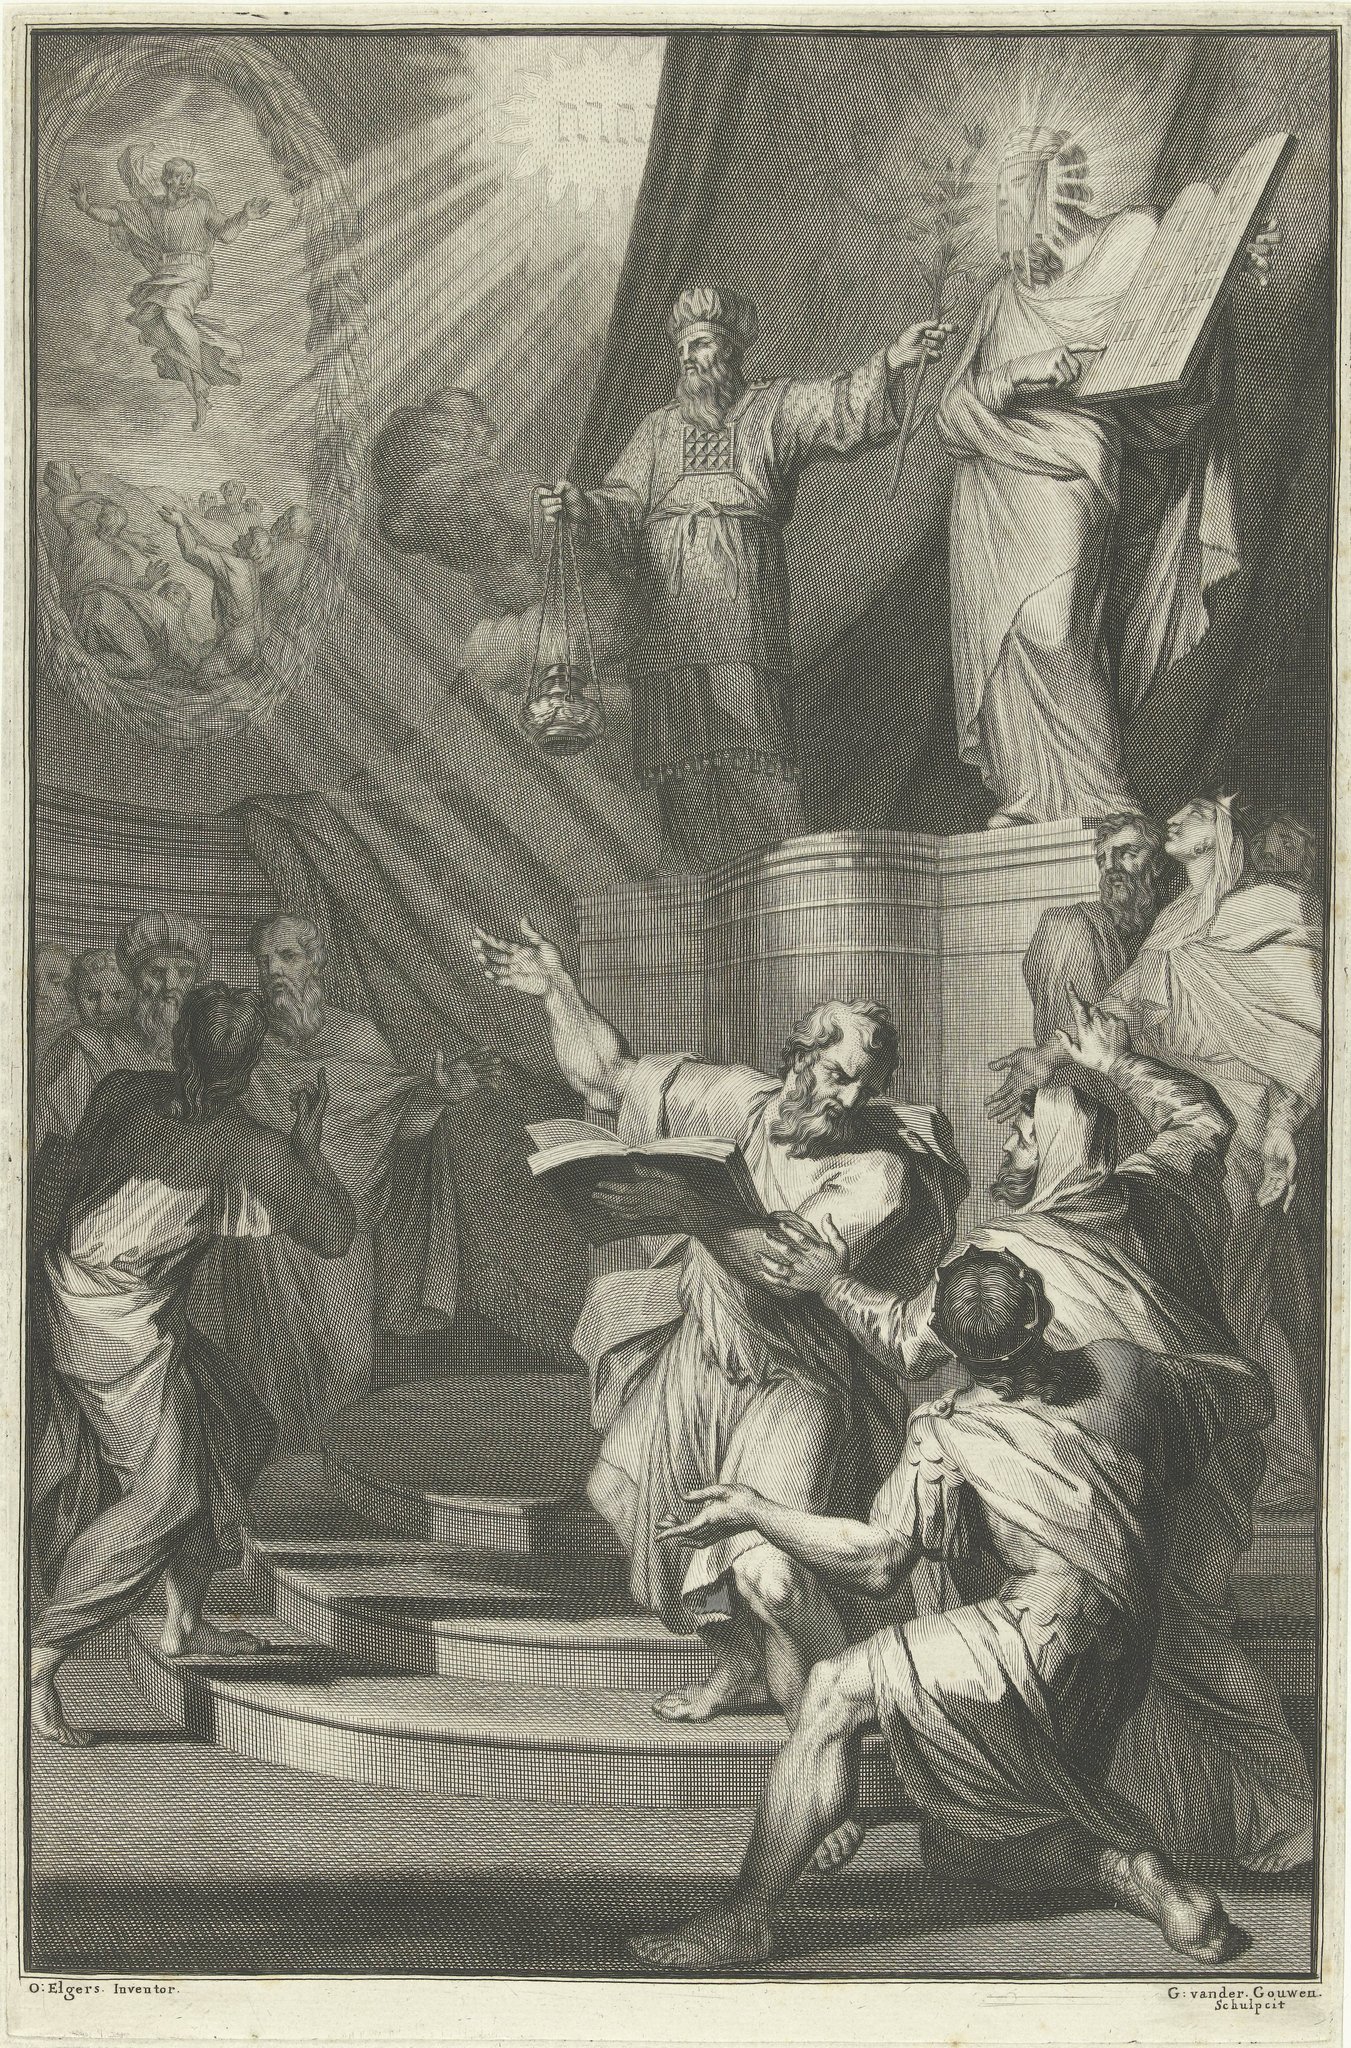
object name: print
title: Titelpagina voor David Martin, Historie des Ouden en Nieuwen Testaments, 1700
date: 1670-1740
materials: paper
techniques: engraving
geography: amsterdam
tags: moses comes down with the new tablets and is awaited by aaron and the assembled people, who notice that 'his face is shining' (moses' face is depicted with rays of light or with horns), tetragram (in hebrew script) ~ jewish religion, christ aloft in the sky ~ ascension, moses covers his face with a veil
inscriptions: collector's mark: Lugt 240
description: Op een voetstuk de hogepriester Aäron en de gesluierde Mozes. Rondom hen het Joodse volk. Mozes toont de Israëlieten de tafelen der wet. In de achtergrond het tetragram en een voorstelling van de hemelvaart van Christus